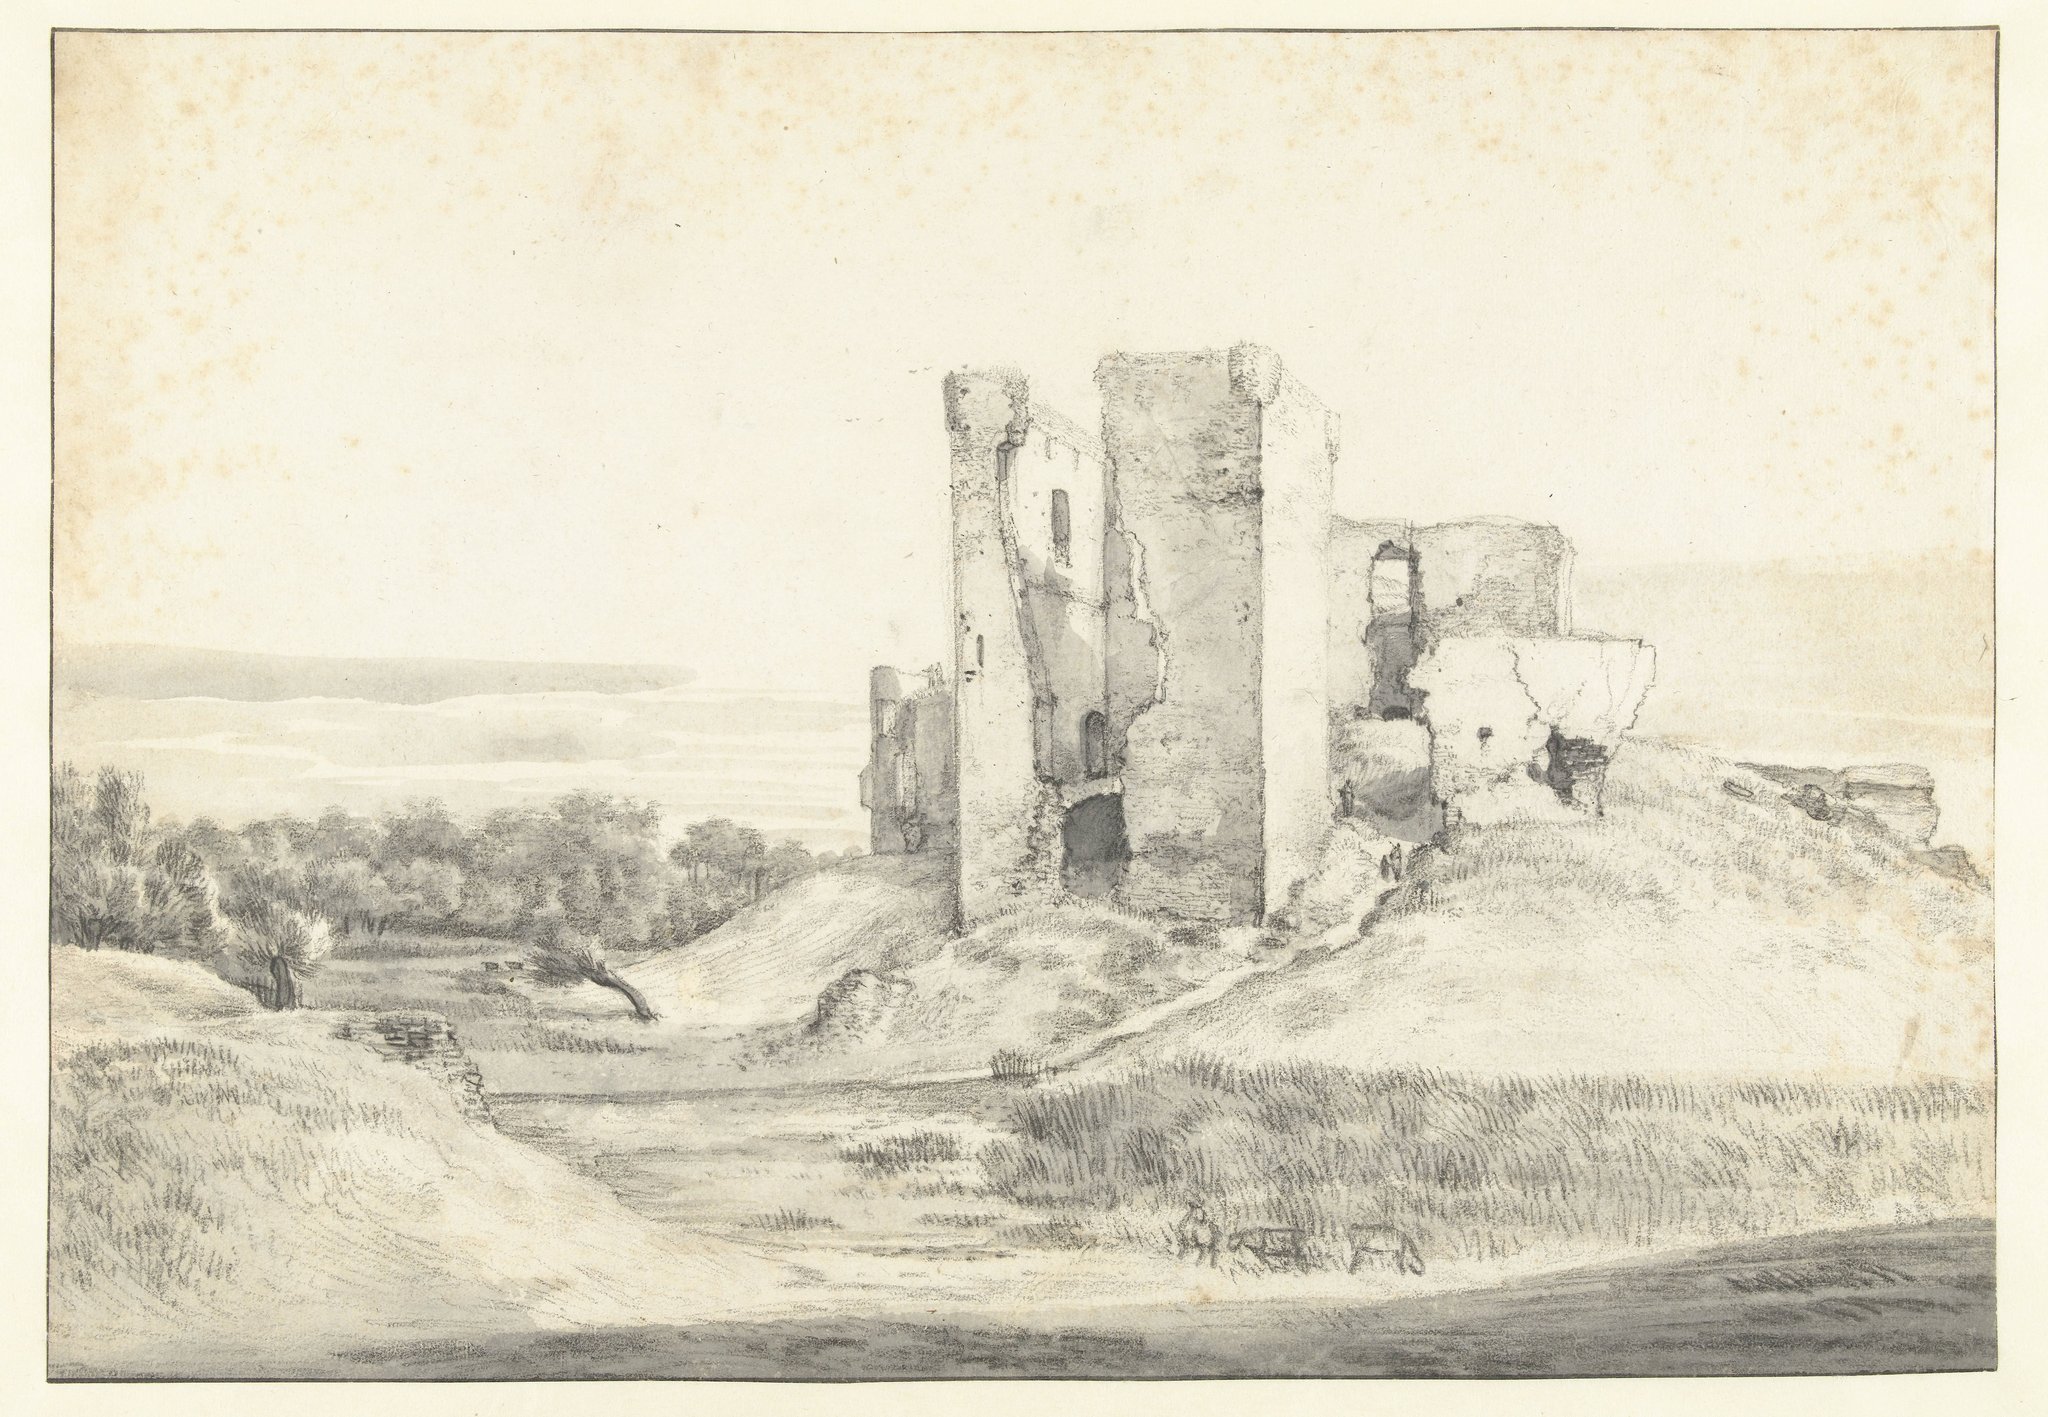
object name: drawing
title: View of Kasteel Oostvoorne, Seen from the West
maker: roelant roghman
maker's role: draughtsman, painter, print maker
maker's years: 1627-1692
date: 1646-1647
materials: chalk, ink, paper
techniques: brush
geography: oostvoorne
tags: castle, ruin of a building ~ architecture, oostvoorne